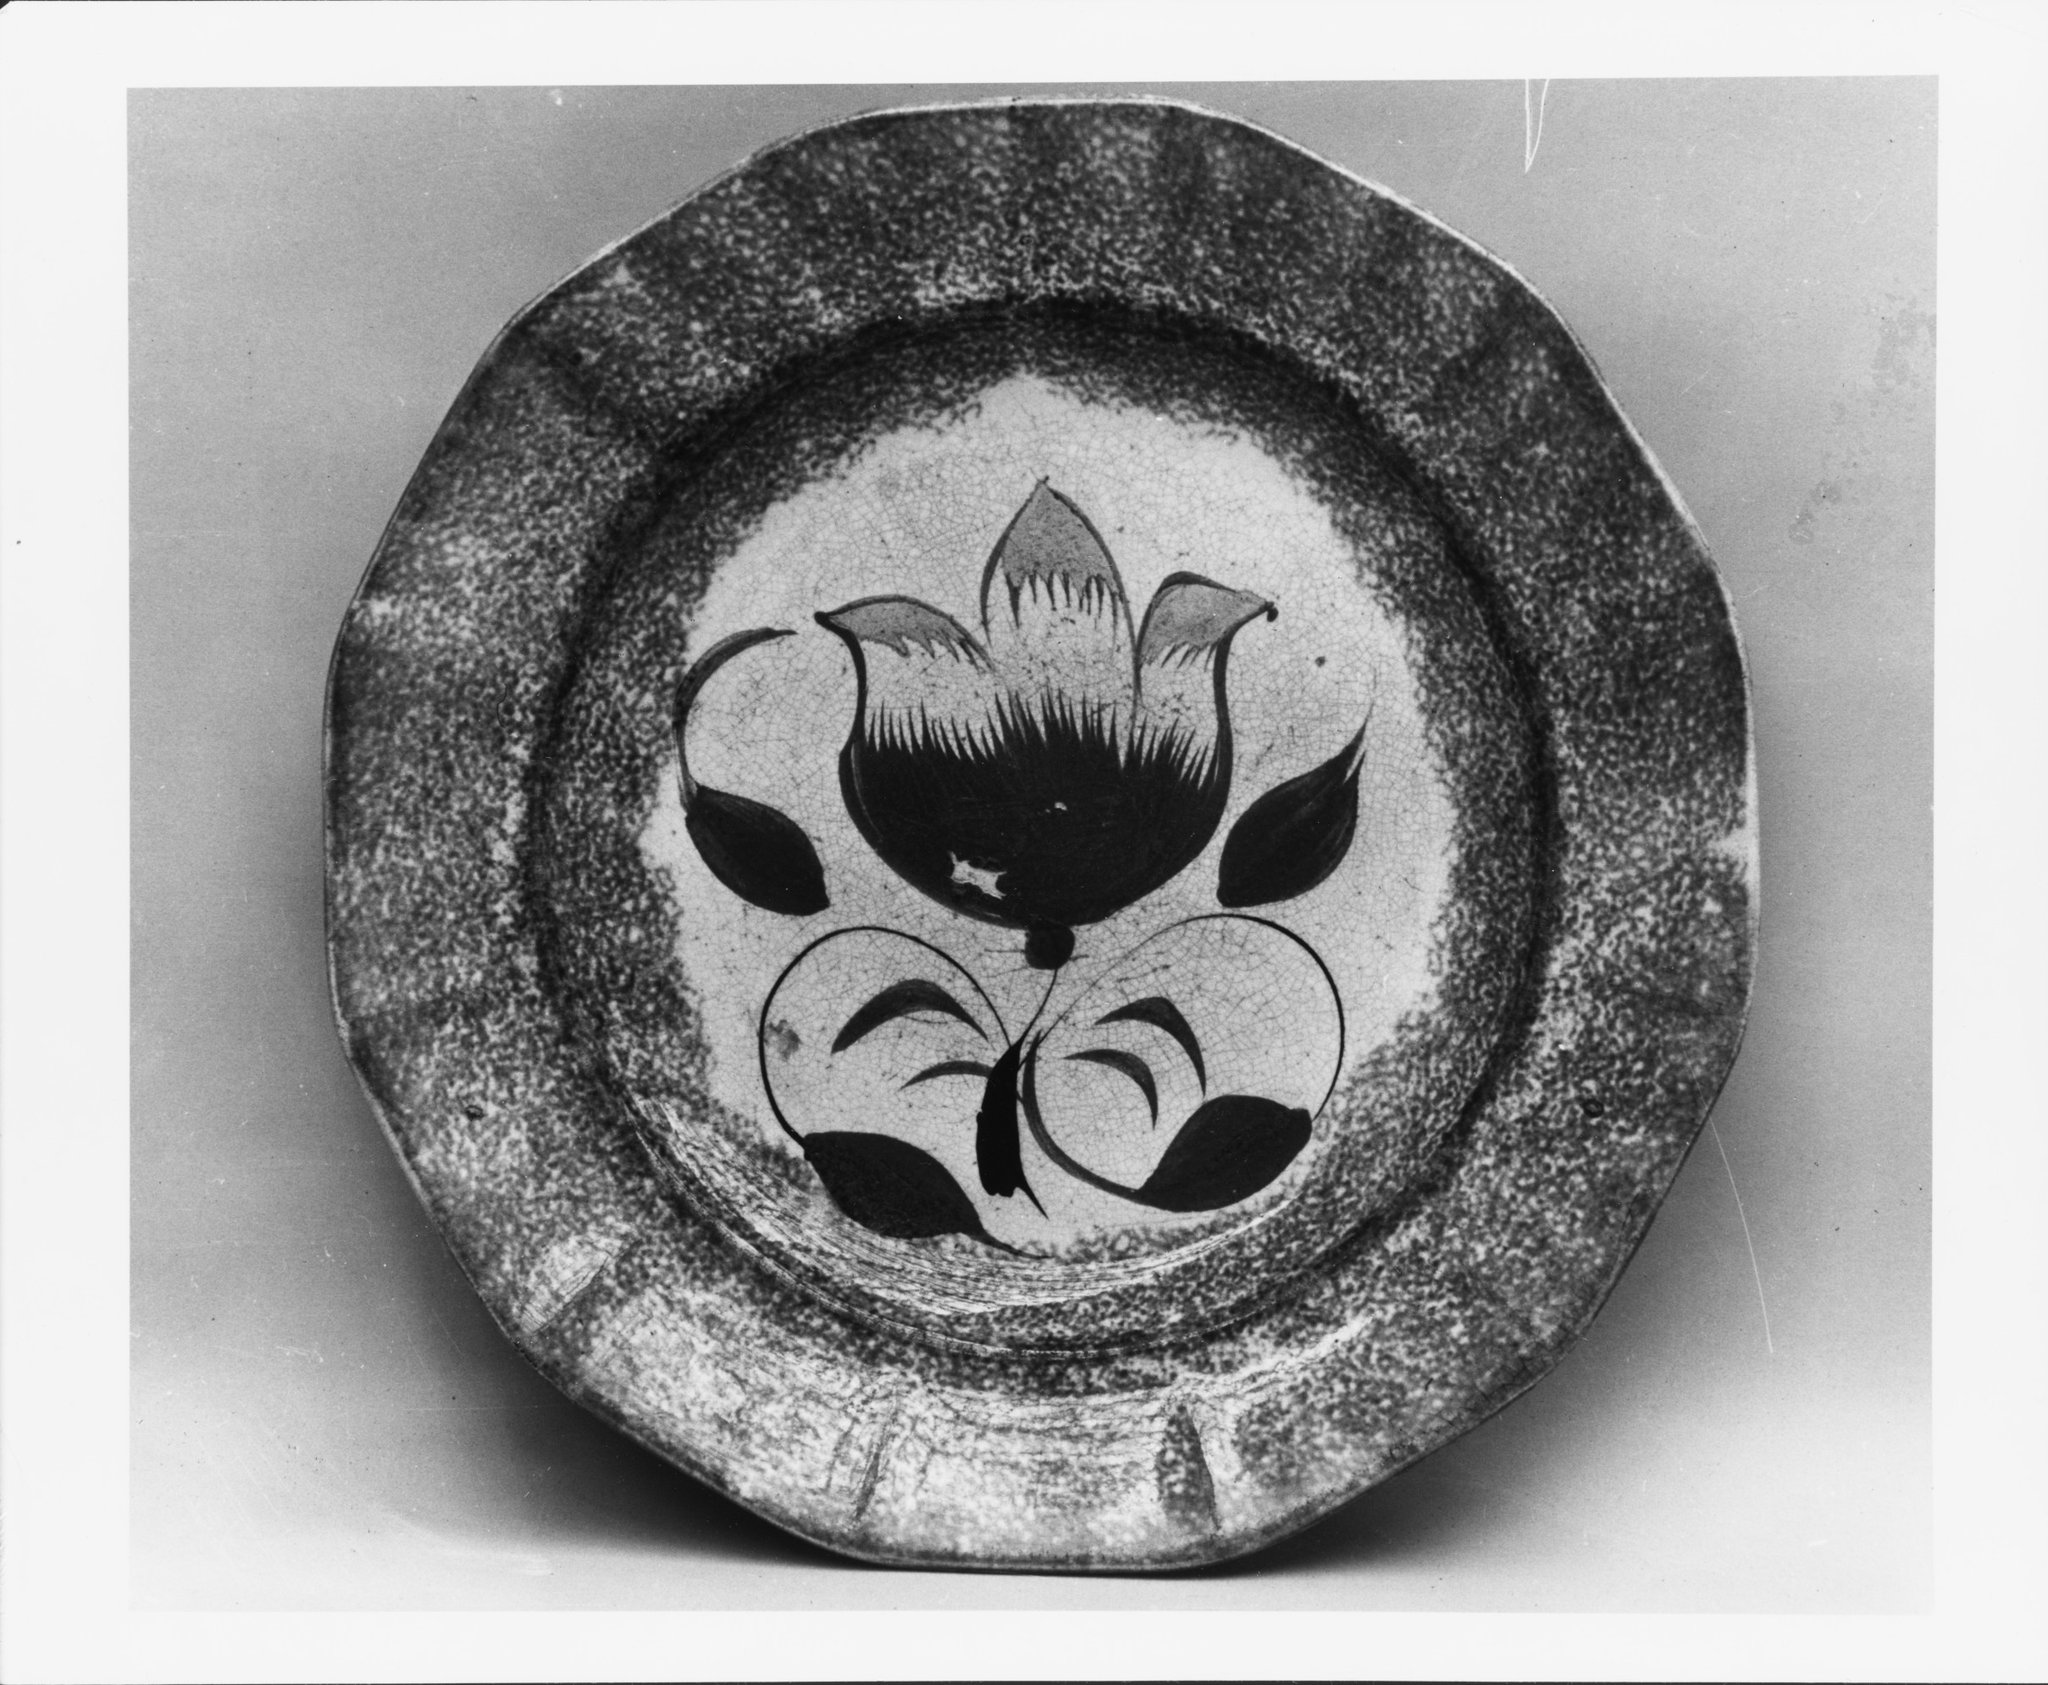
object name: plate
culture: british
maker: barker and till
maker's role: maker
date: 1800-1830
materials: earthenware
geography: england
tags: flowers